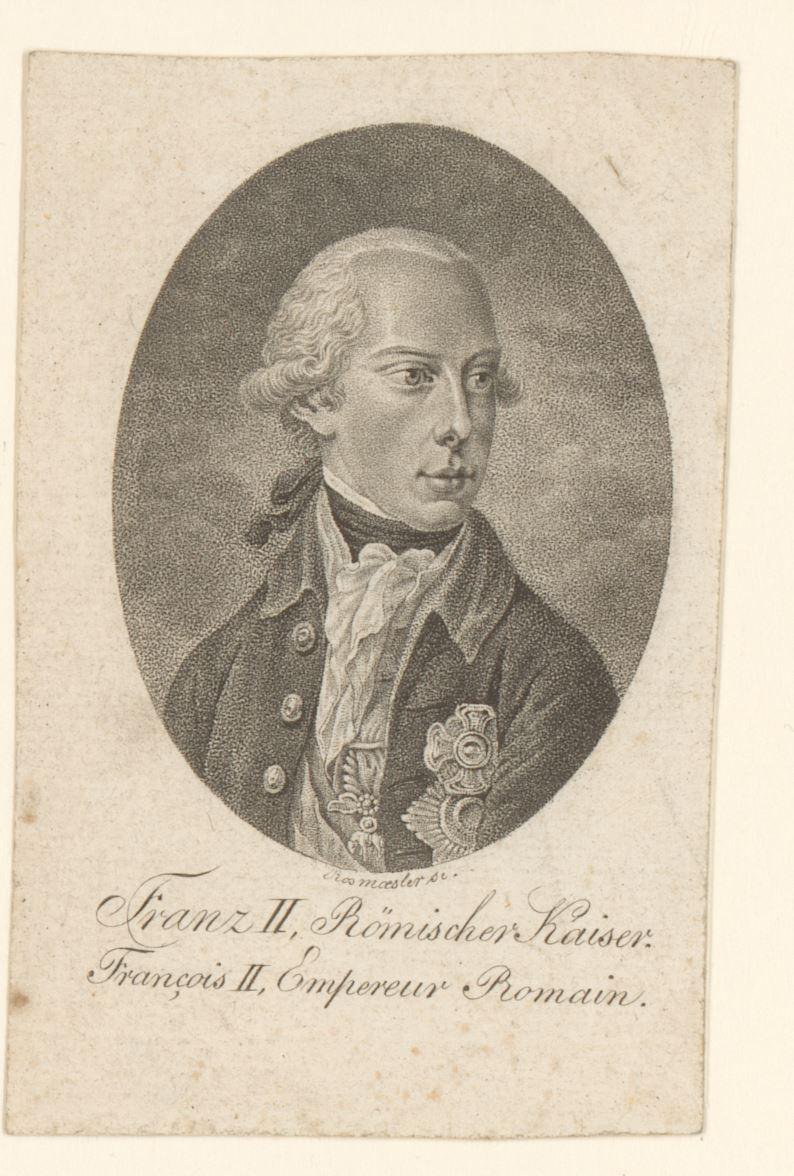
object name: print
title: Portret van Frans II Josef Karel, Rooms-Duits keizer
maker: friedrich rossmässler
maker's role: print maker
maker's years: 1775-1858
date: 1785-1858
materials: paper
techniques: engraving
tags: vienna, frans ii (rooms-duits keizer), knighthood order (with name) - insignia of a knighthood order, e.g.: badge, chain (with name of order), historical persons, medals and other marks of military honour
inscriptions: collector's mark: Lugt 2228